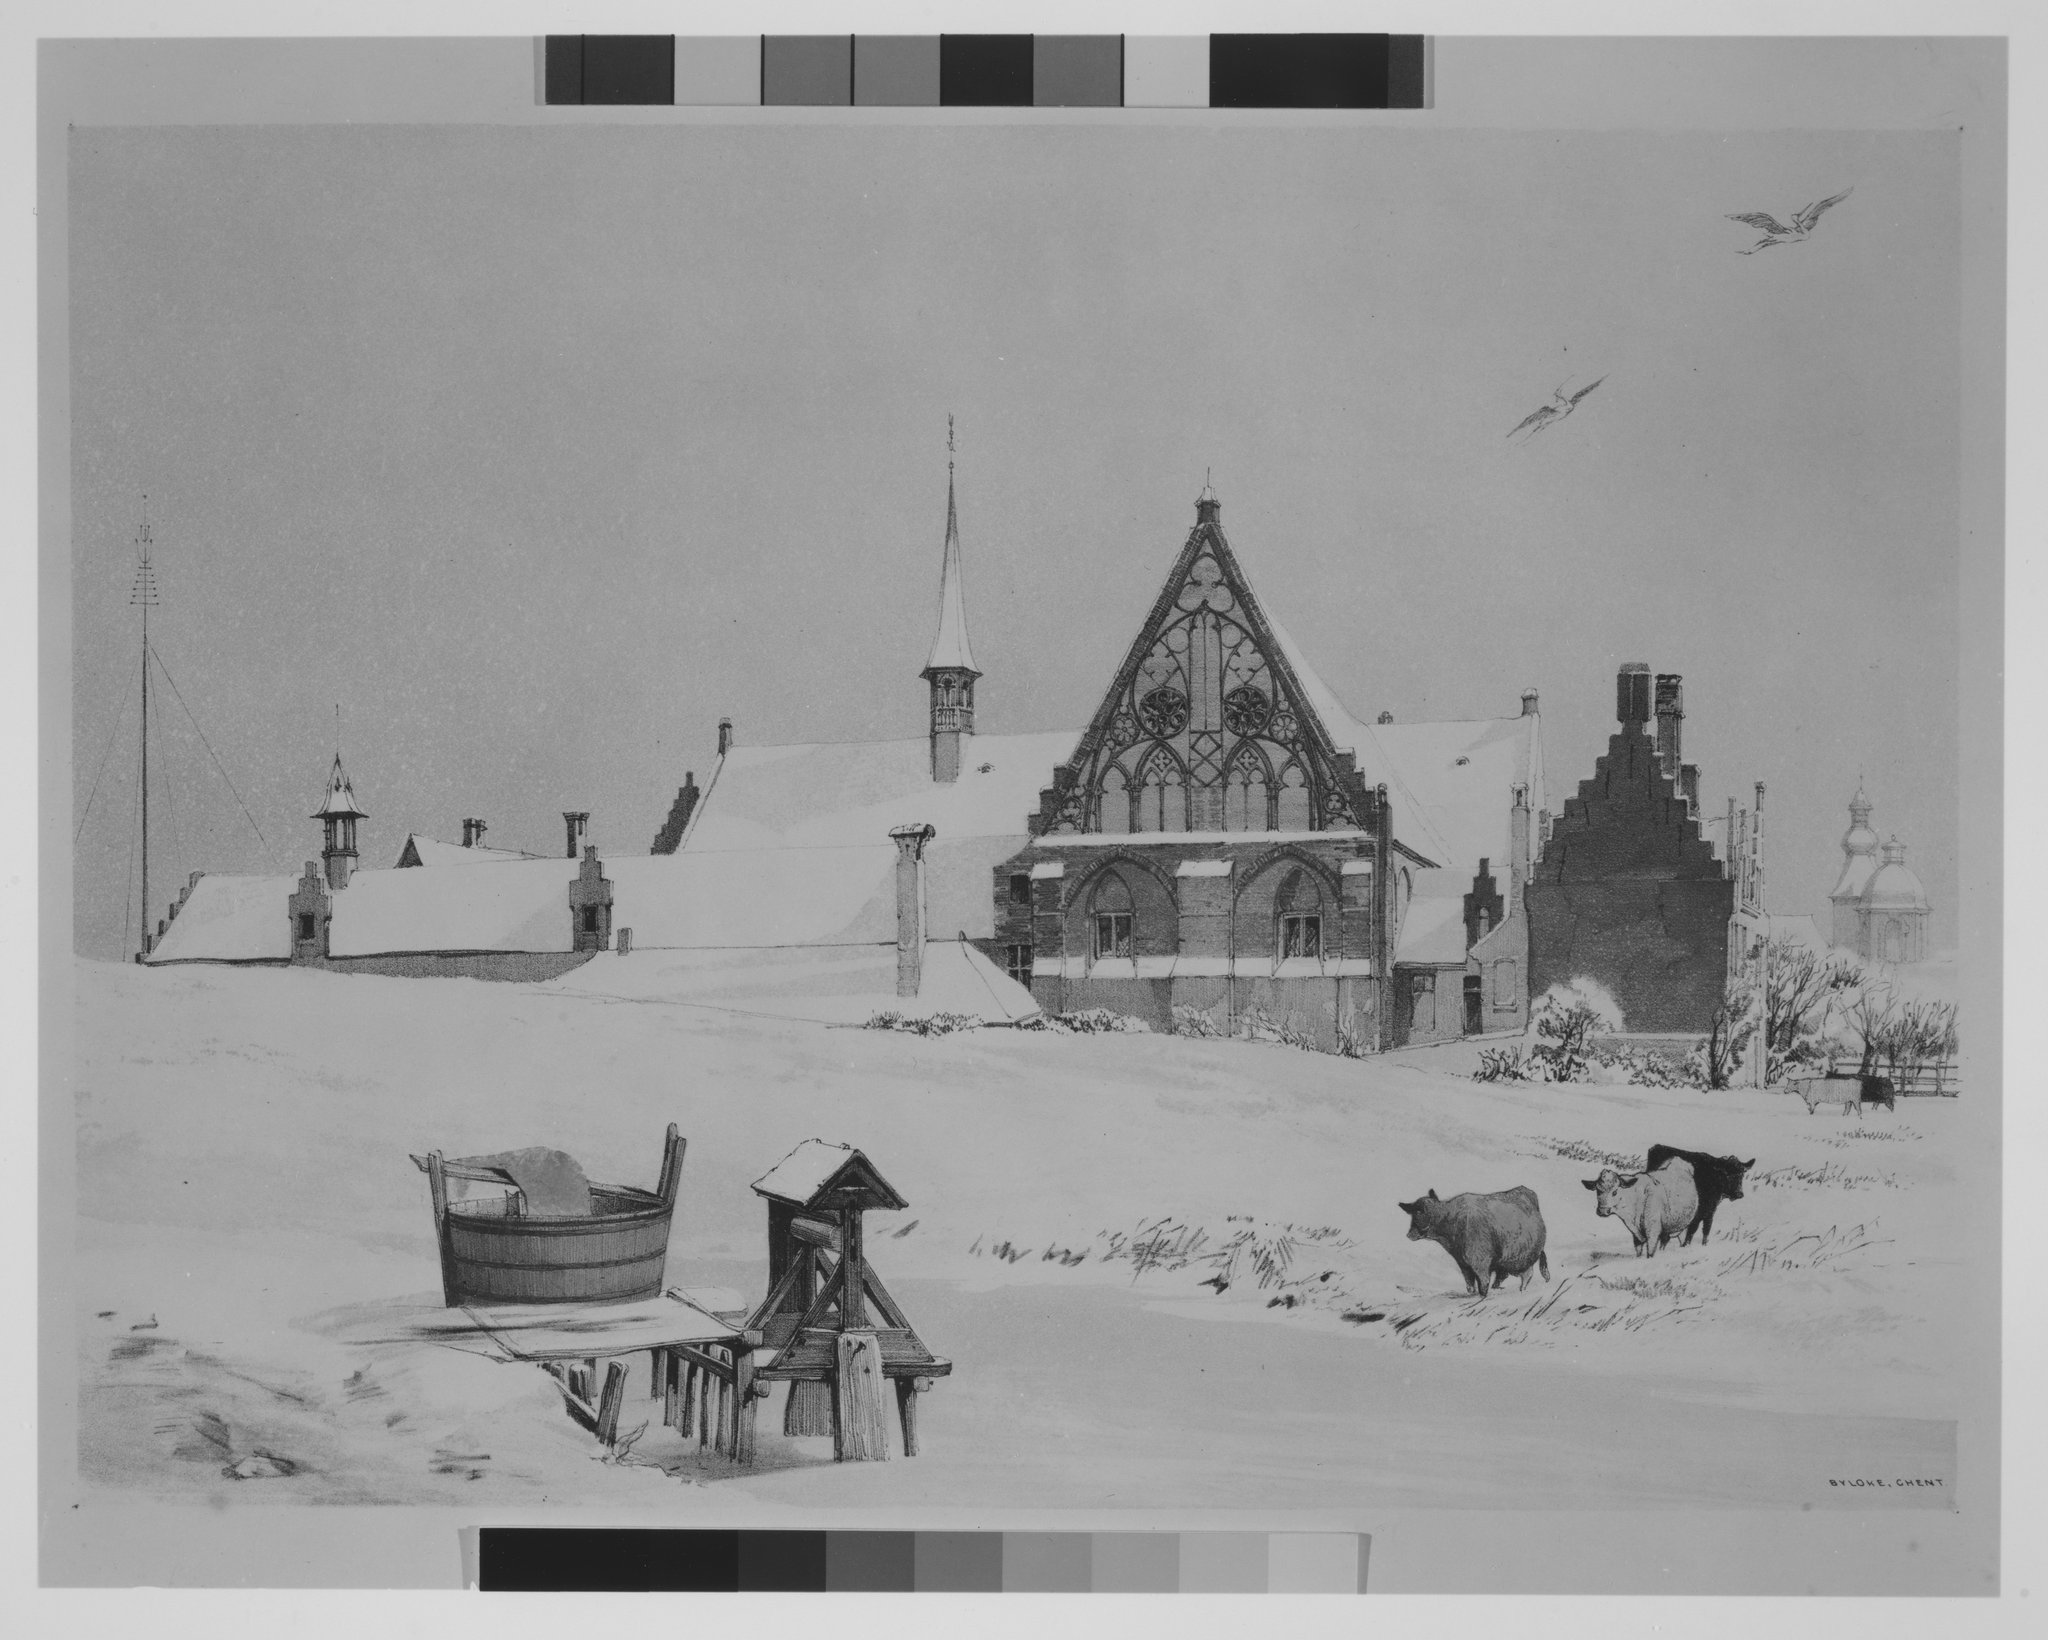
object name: print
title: Byloke, Ghent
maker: thomas shotter boys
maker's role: artist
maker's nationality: british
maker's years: 1803-1874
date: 1839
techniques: hand coloring, lithograph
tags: buildings,cows,snow